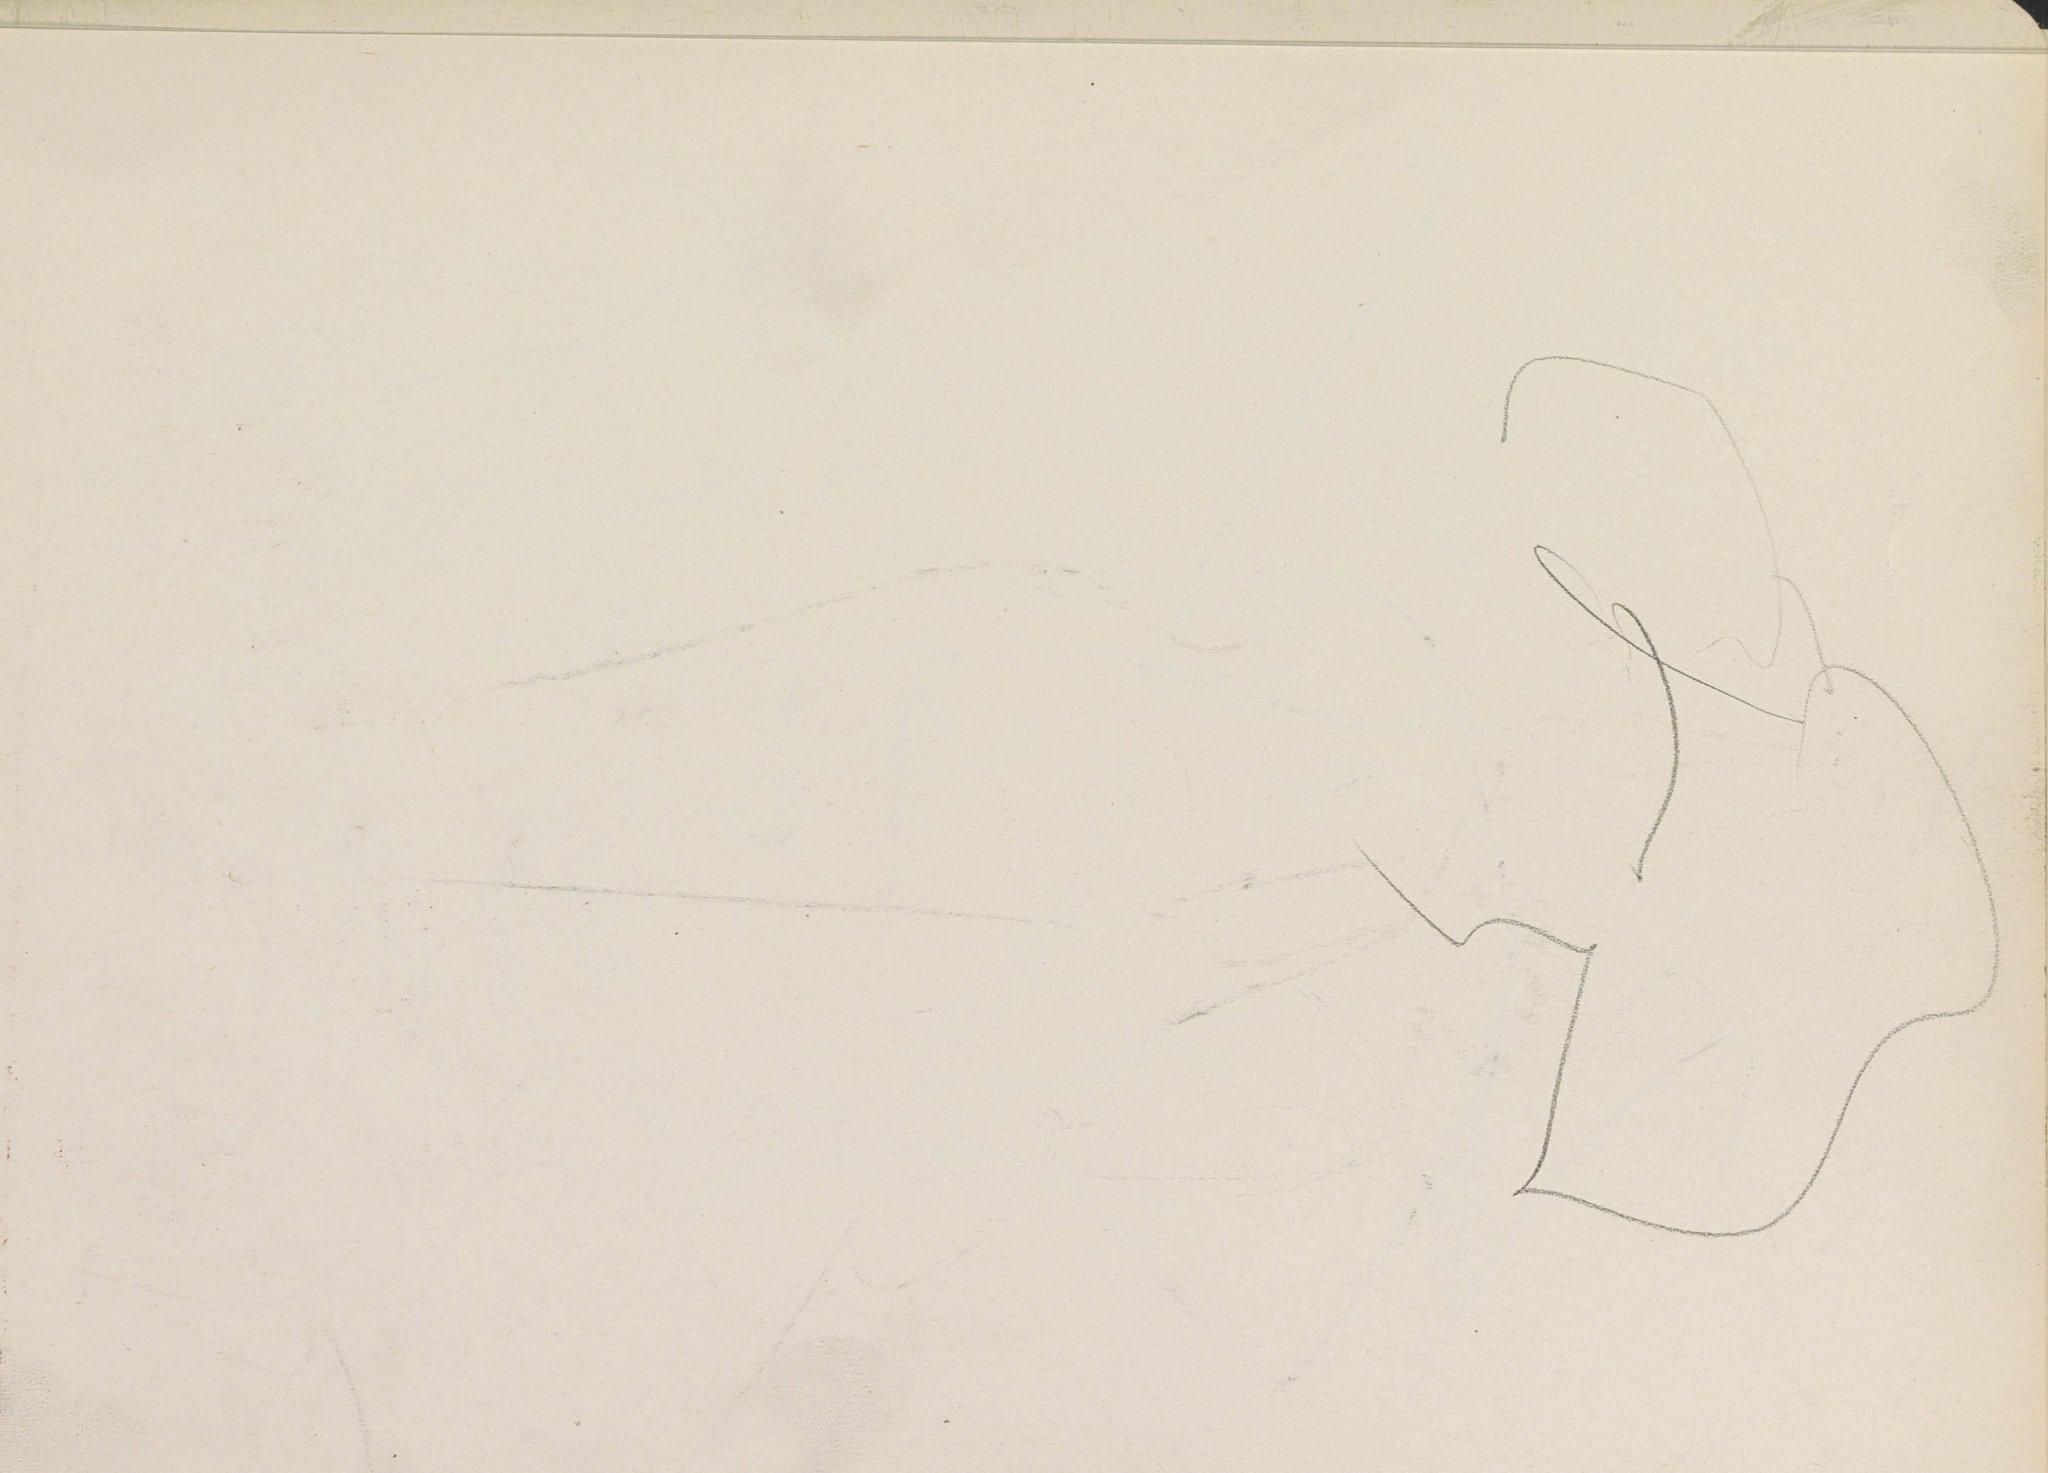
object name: sketchbook leaf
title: Studie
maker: isaac israels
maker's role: draughtsman, painter, print maker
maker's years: 1865-1934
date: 1915-1934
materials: paper, pencil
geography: the hague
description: Blad 29 recto uit schetsboek VI met 33 bladen.